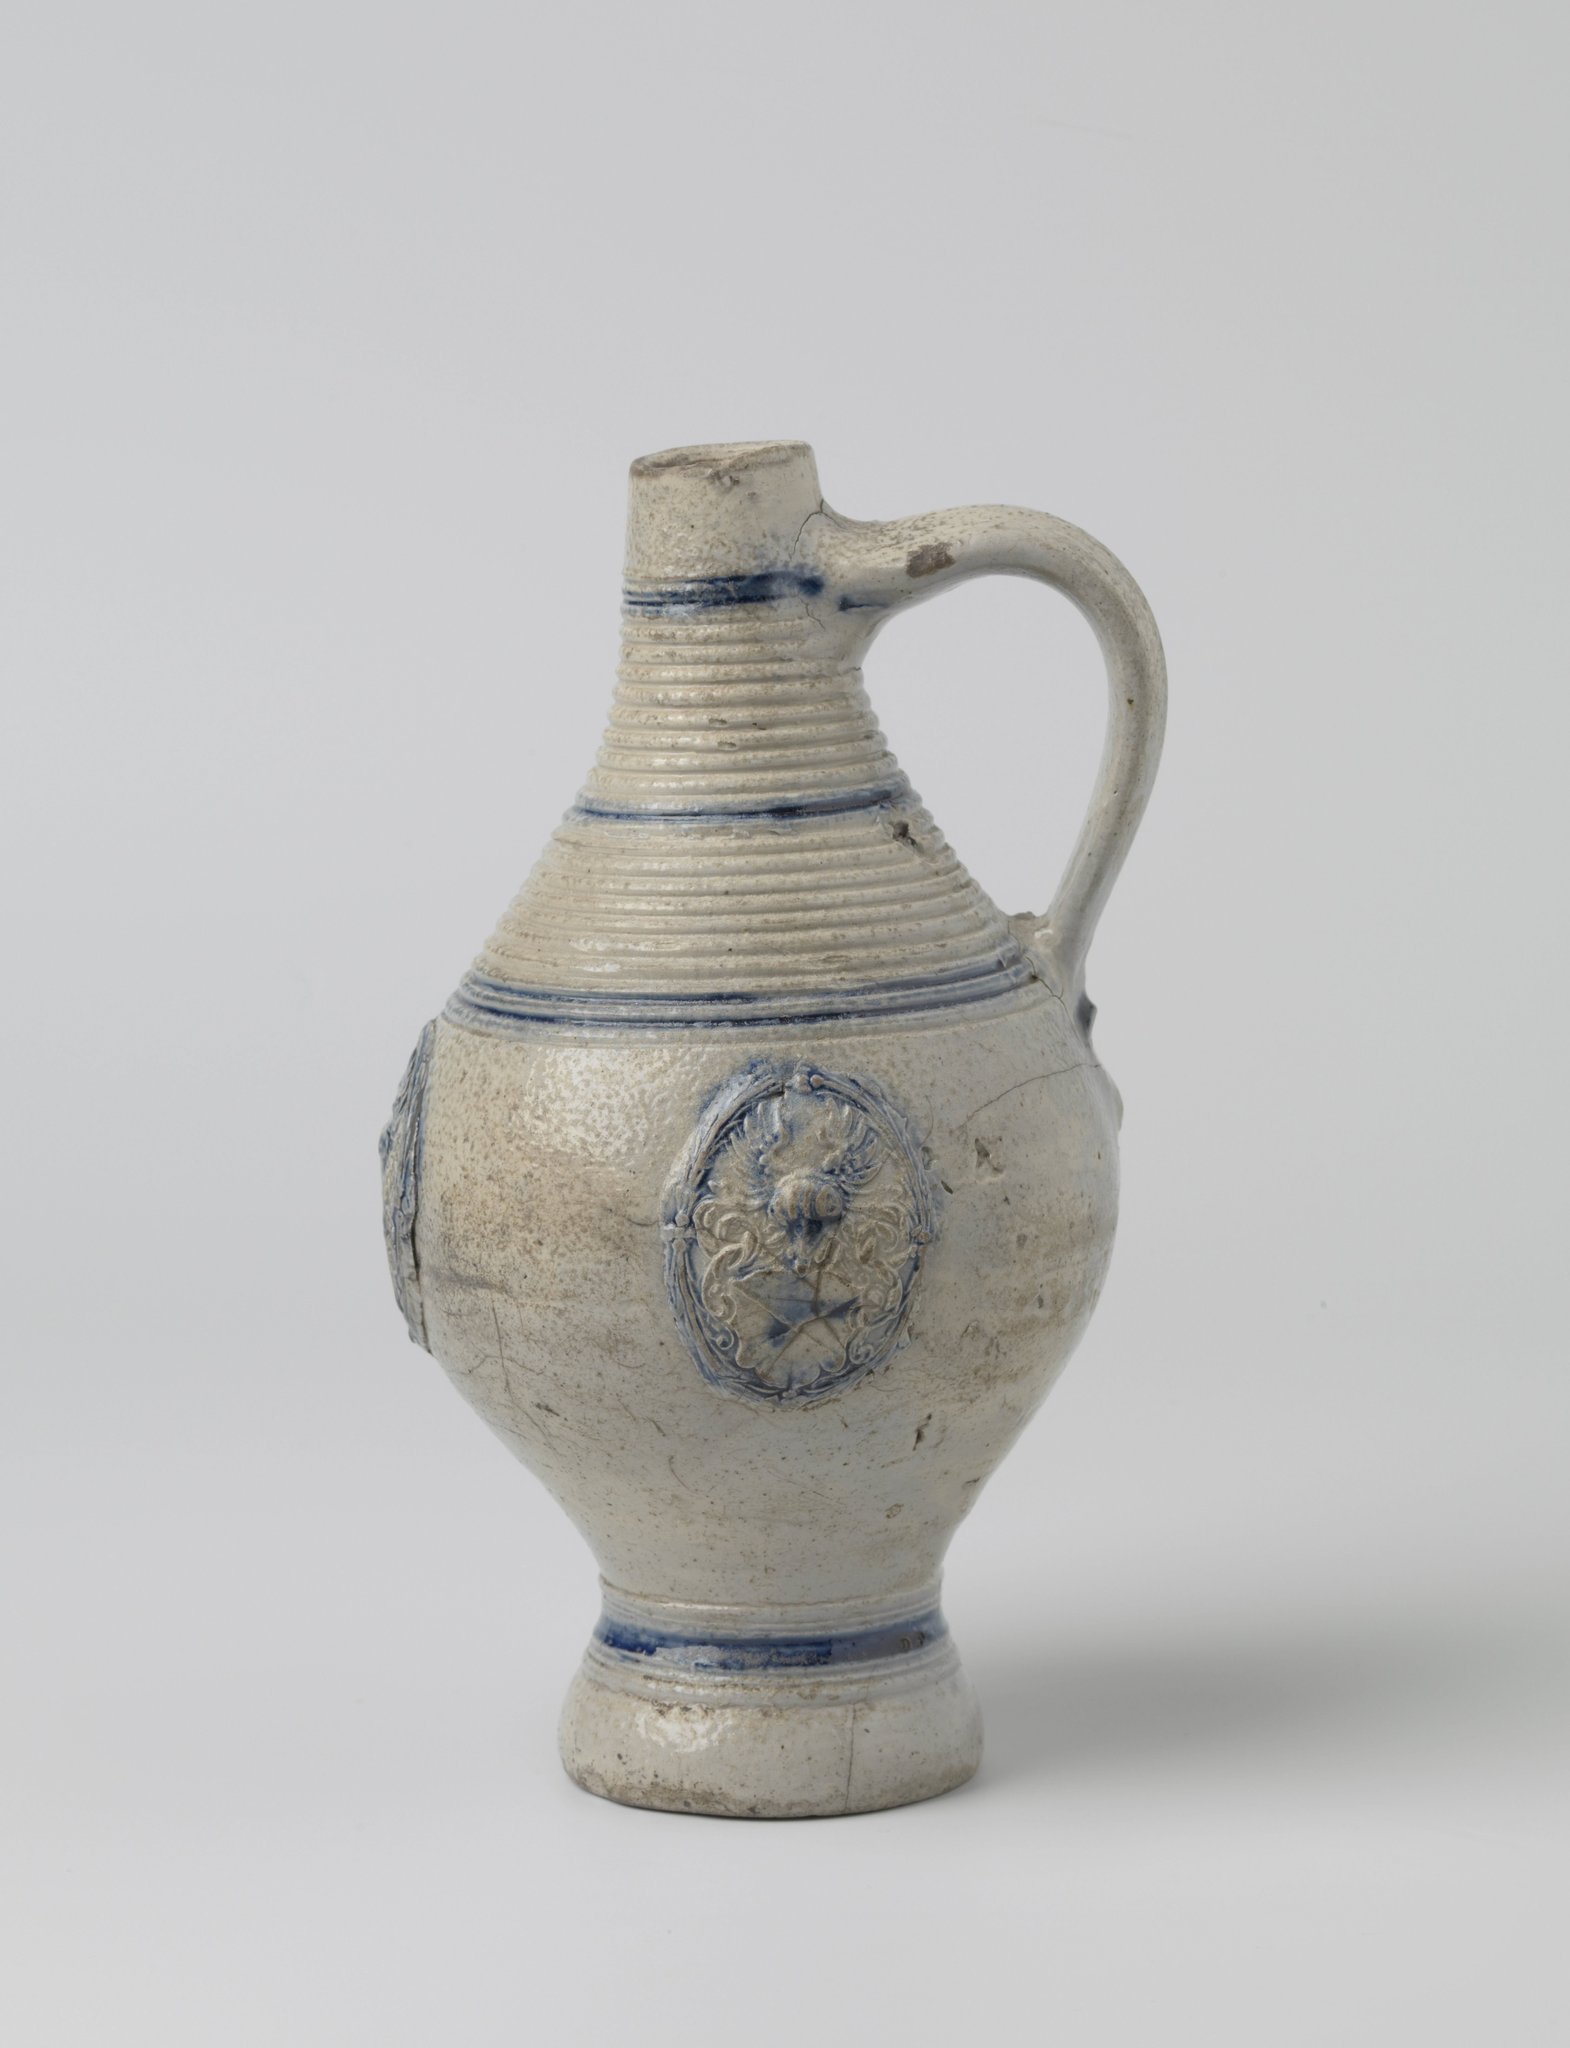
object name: jug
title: Jug with three coat of arms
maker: Anonymous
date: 1600-1649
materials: cobalt, glaze, stoneware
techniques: firing, forming, relief, turning, vitrification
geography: westerwald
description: Kruik van steengoed op hoge voet met een eivormig lichaam en taps toelopende nek. Het C-vormige oor is bevestigd aan de nek en de schouder. Een brede band profielen op de nek en schouder, enkele op de voet. Gedeeltelijk bedekt met kobaltblauw. Op de buik driemaal een gedrukt en opgelegd wapen met een kruis op het schild, bladranken en een gevleugeld helmteken. Blauwe lijnen op de nek en voet. Westerwald.